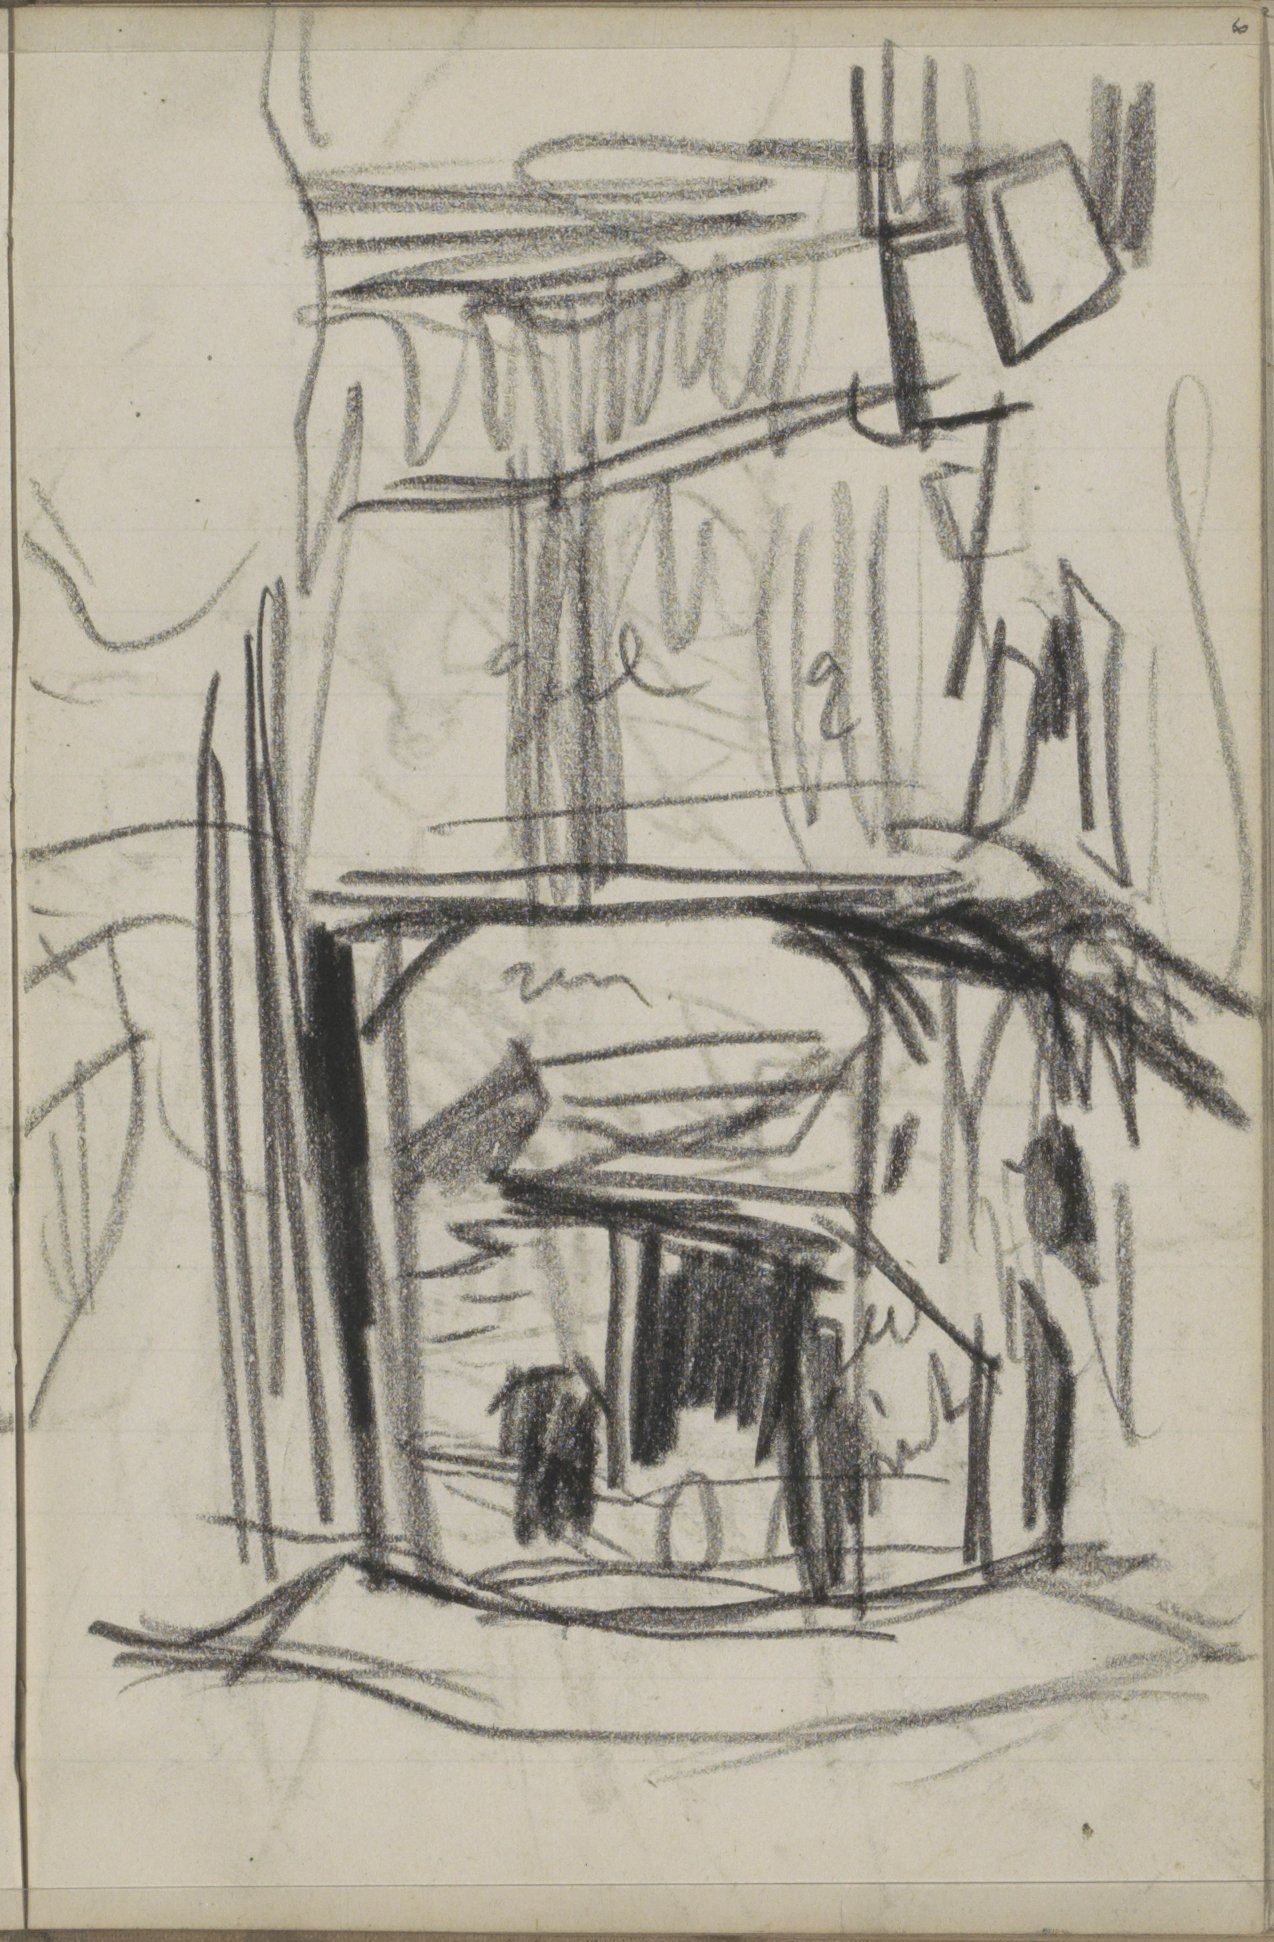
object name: sketchbook leaf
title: Architectuurstudie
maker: marius bauer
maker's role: draughtsman, print maker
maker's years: 1867-1932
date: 1888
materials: chalk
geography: istanbul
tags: architecture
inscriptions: kleurnotitie, handgeschreven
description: Pagina 60 uit een schetsboek met 56 bladen.